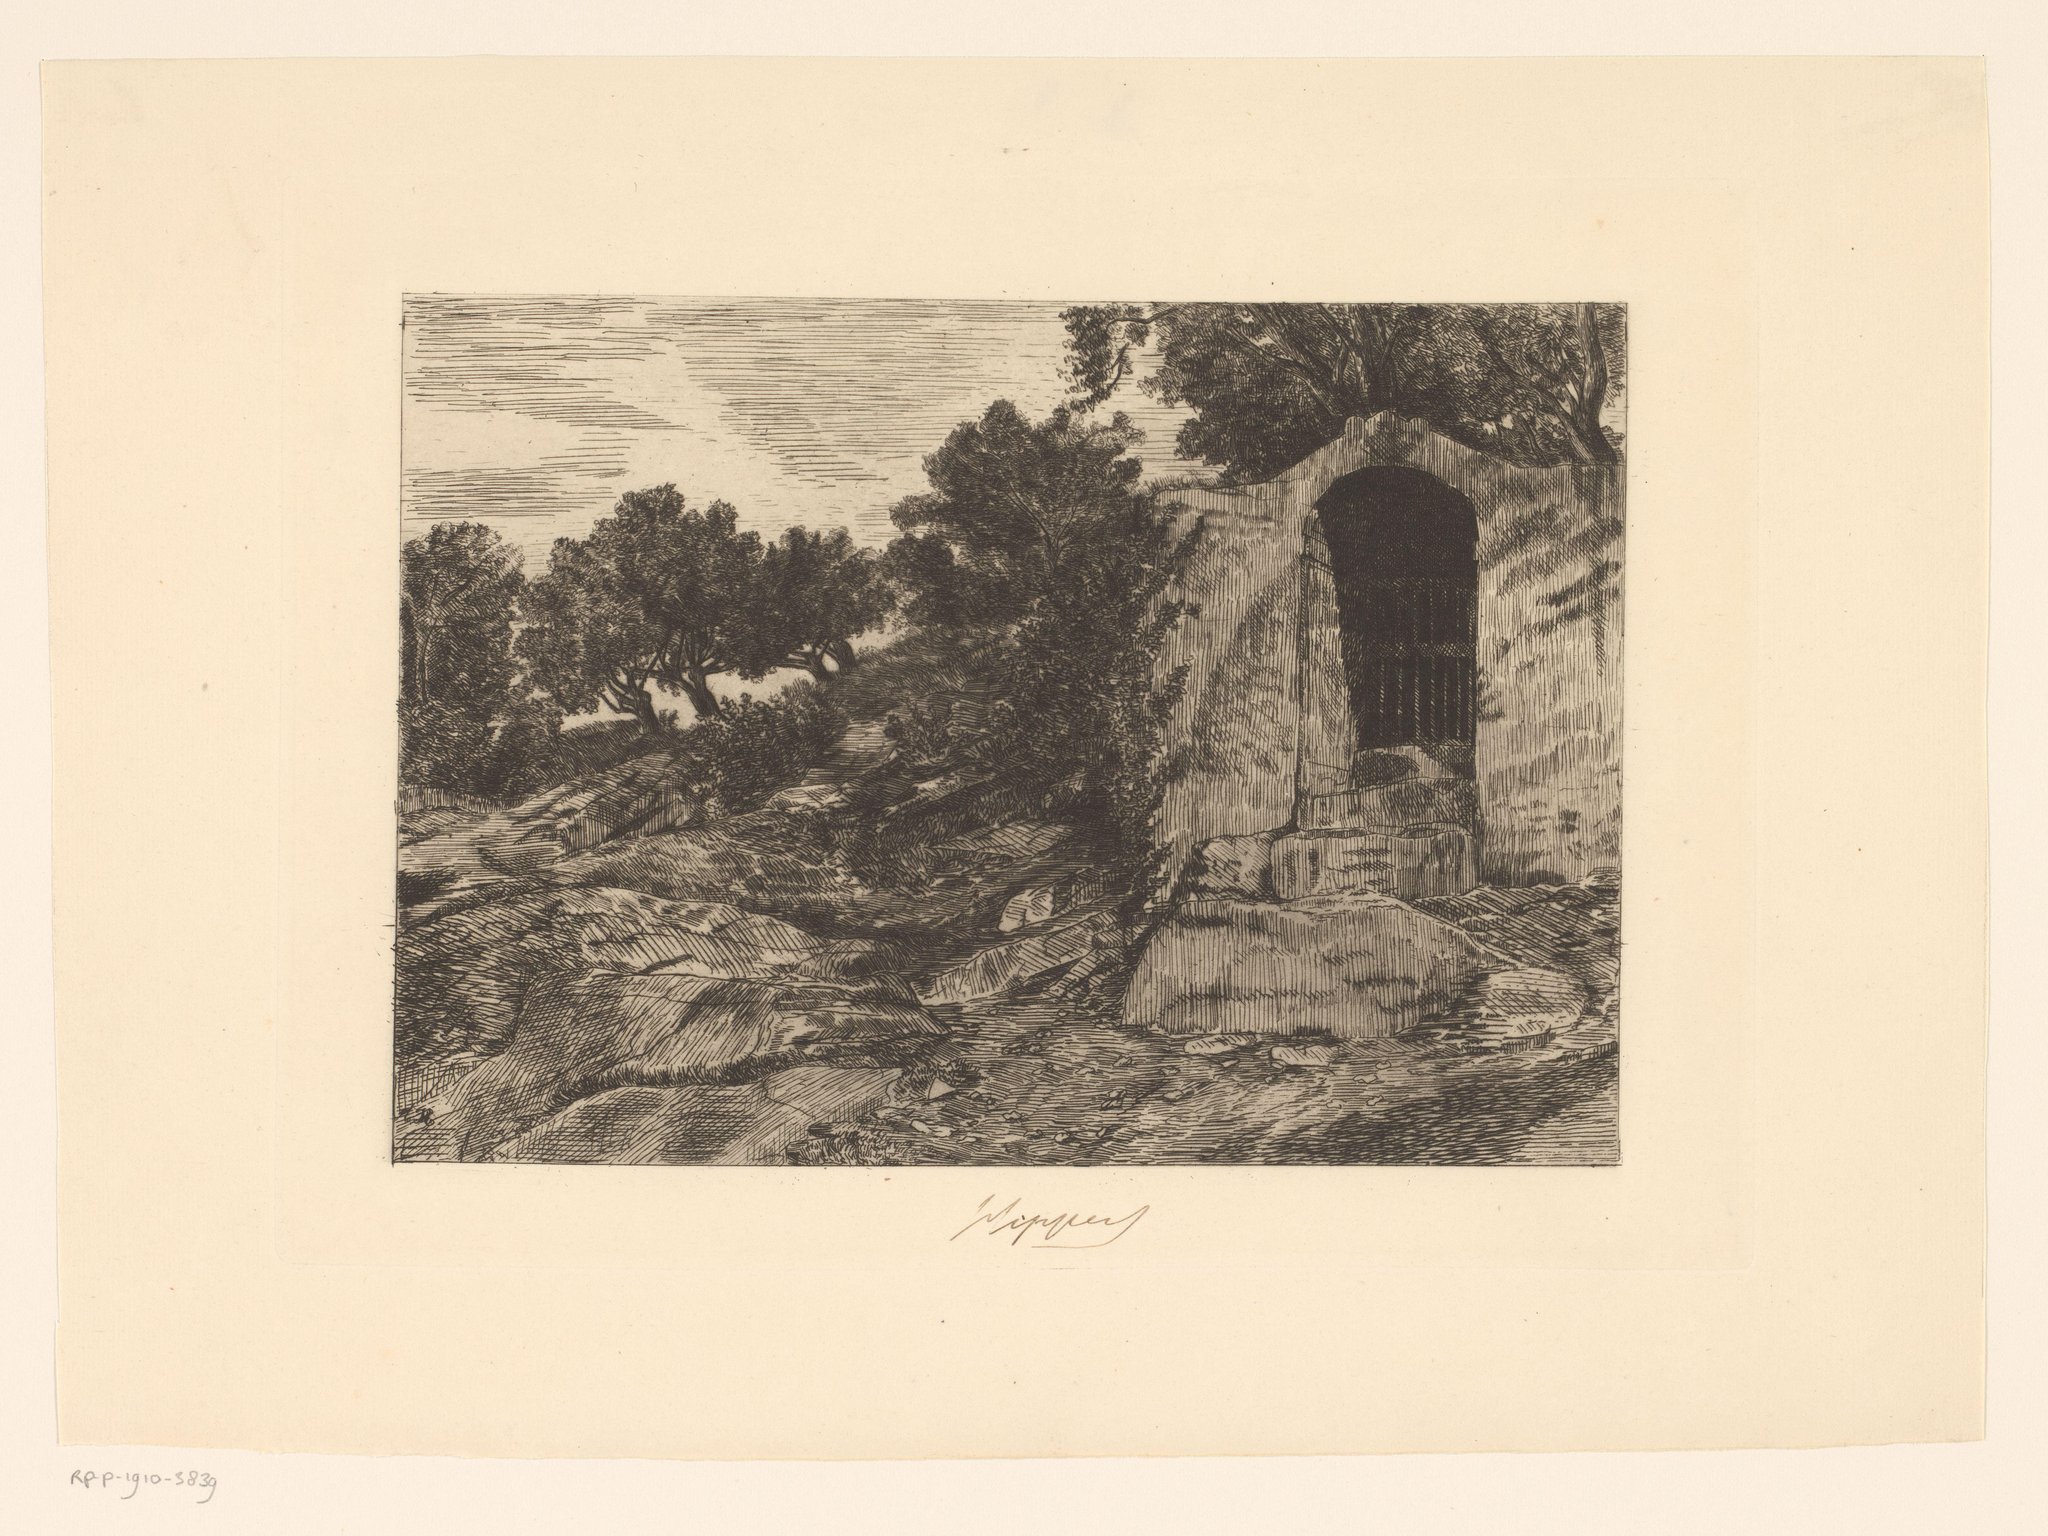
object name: print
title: Kapelvormige ruïne met hek in rotsachtig landschap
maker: karel theodoor hippert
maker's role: print maker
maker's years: 1839-1919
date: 1849-1910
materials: paper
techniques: etching, intaglio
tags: landscape with ruins, rocks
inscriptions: collector's mark: Lugt 2228